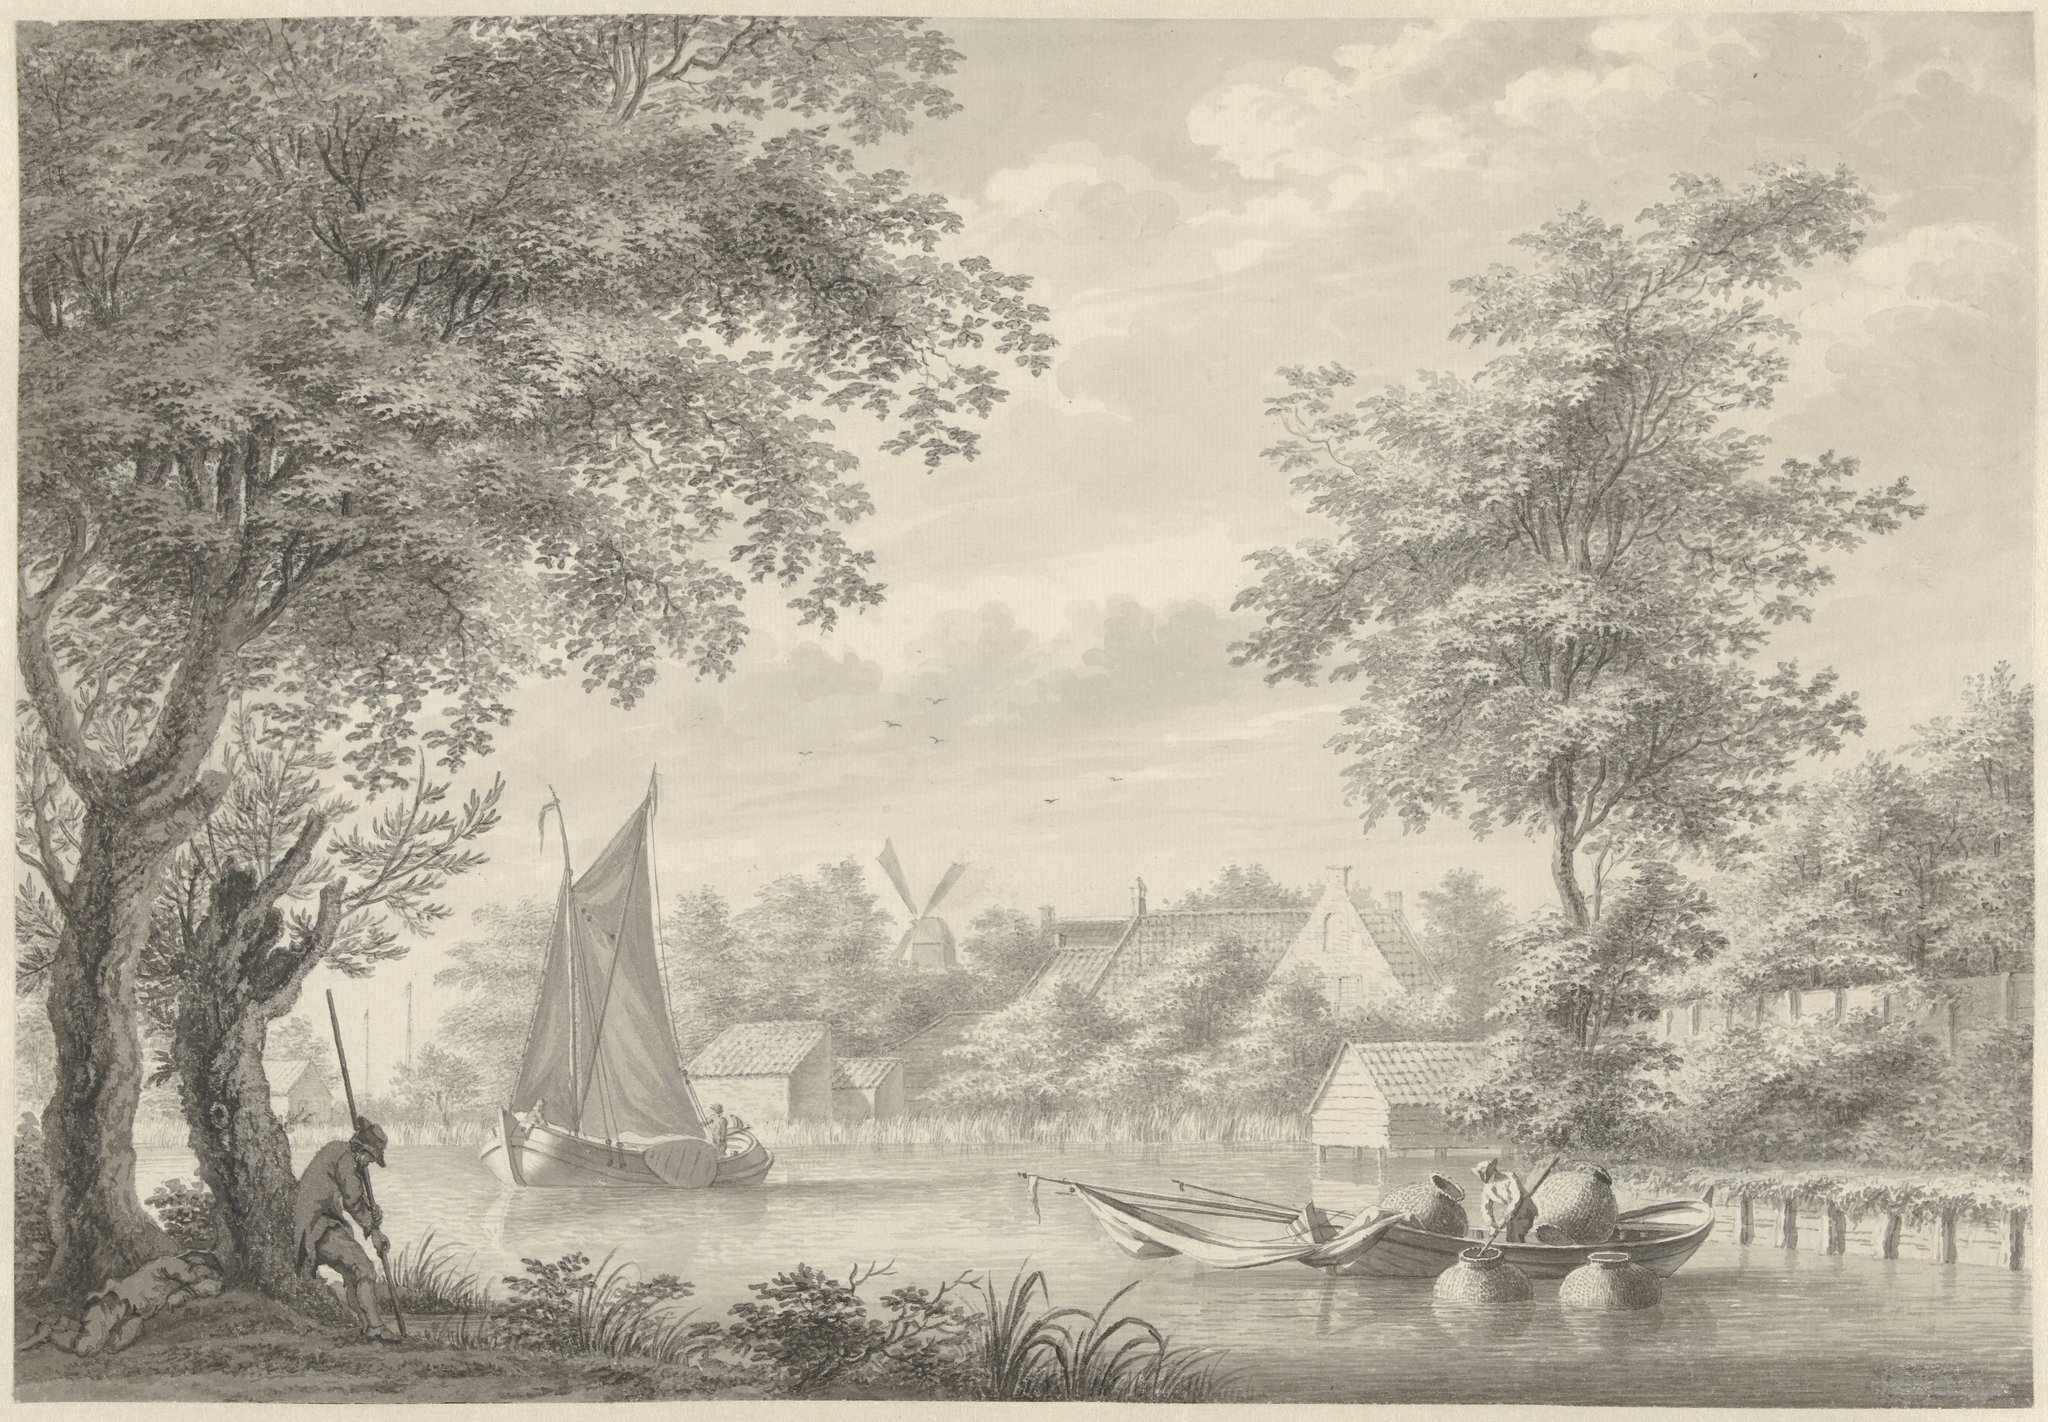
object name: drawing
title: Gezicht op de Schinkel met een zeilschip en een visser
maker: gerard van rossum (1698/99-1772)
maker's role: draughtsman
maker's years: 1698-1772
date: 1762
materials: ink, paper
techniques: brush, pen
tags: river, fresh-water fishery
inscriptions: inscription: ‘GV.Rossum. 1762 / fecit / Aan den Schinkel’